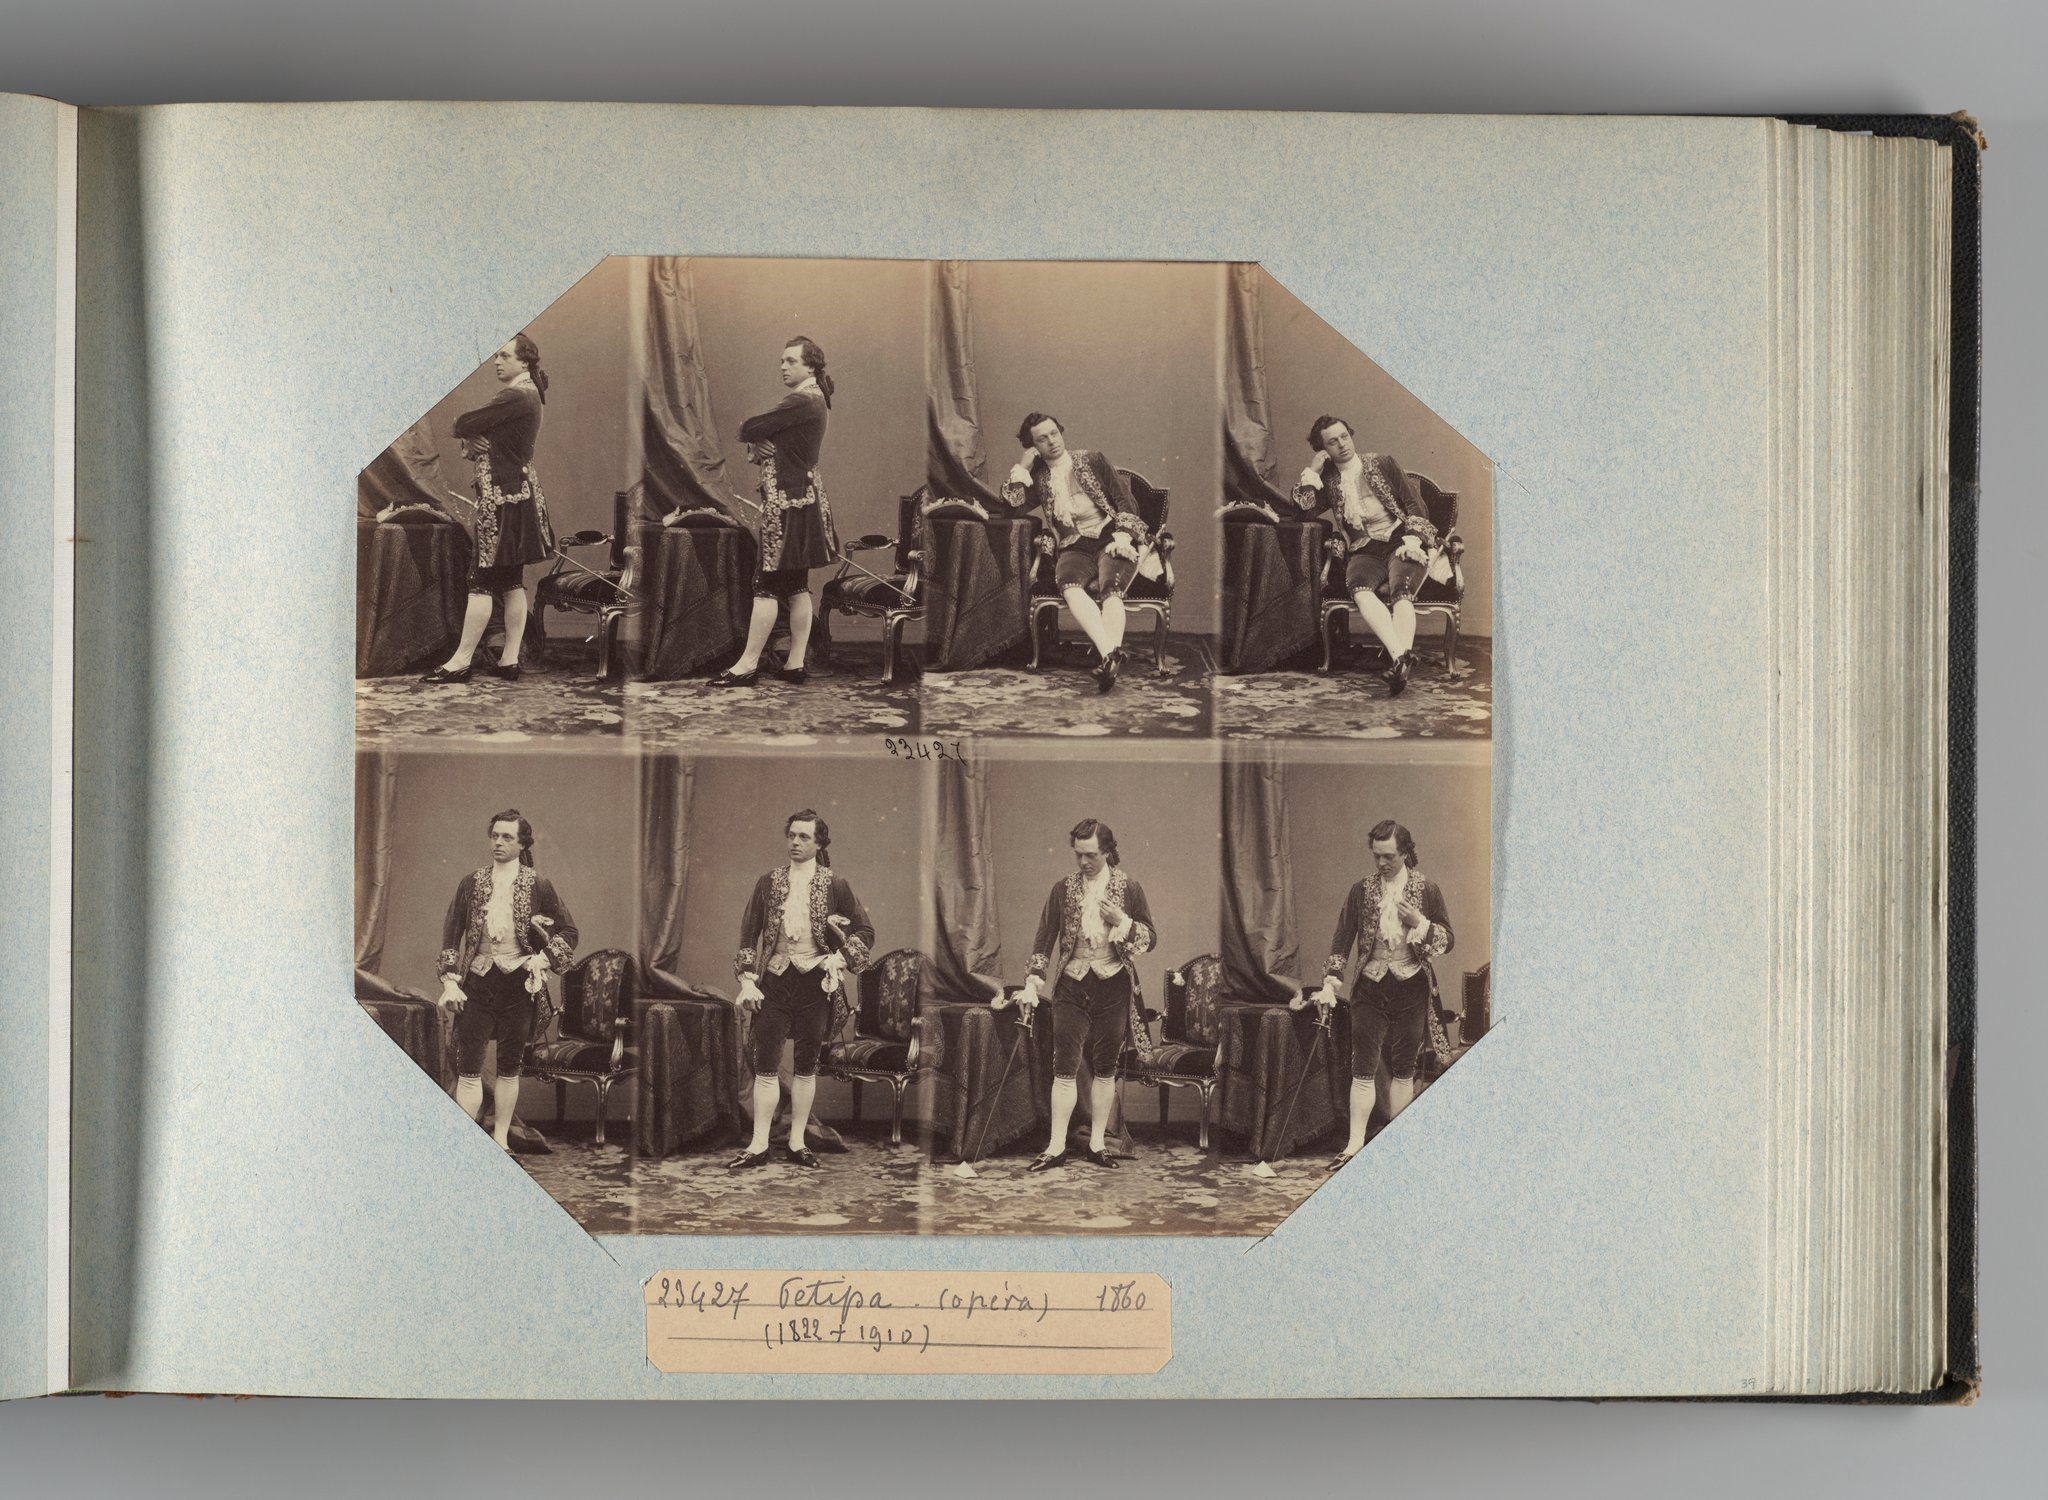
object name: photograph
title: Petipa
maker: andré-adolphe-eugène disdéri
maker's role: artist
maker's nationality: french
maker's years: 1819-1889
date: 1860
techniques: albumen silver print, glass negative